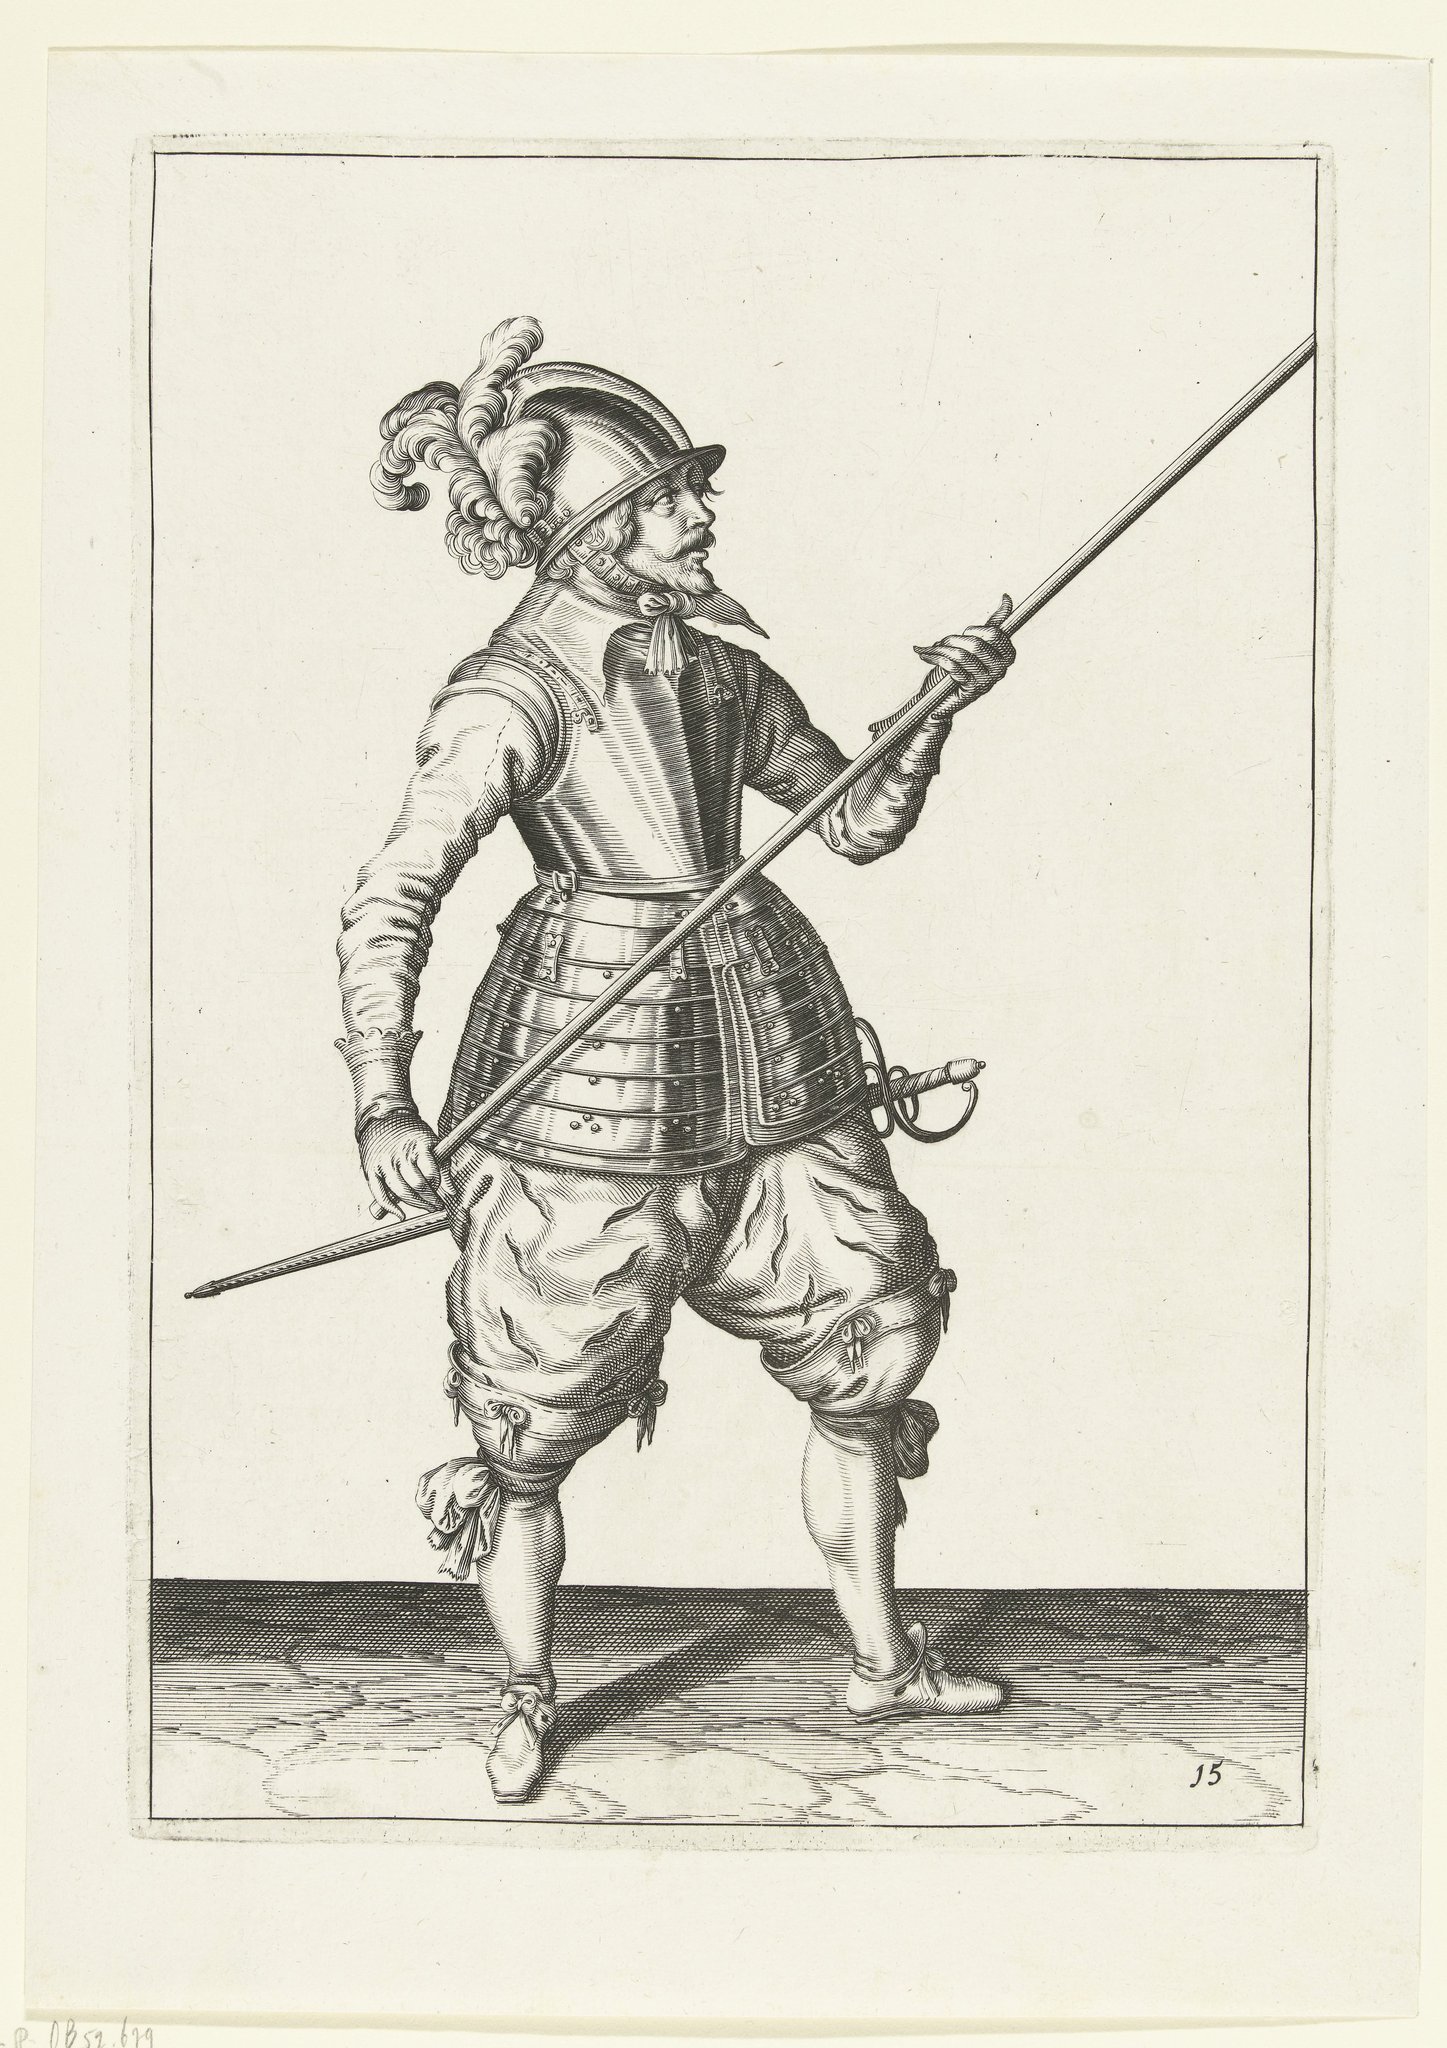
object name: print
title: Soldaat die zijn spies met beide handen bij zijn rechterzijde draagt, de punt schuin omhoog gericht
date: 1597-1607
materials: paper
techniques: engraving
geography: netherlands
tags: manoeuvre ~ military training, warfare; military affairs (+ mercenary troops, e.g.: lansquenets), helved weapons, polearms (for striking, hacking, thrusting): lance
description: Een soldaat, ten voeten uit, die een spies (lans) met beide handen bij zijn rechterzijde draagt, de punt schuin omhoog gericht. Dit is de eerste handeling voor het op de grond plaatsen van de spies. Deze prent is onderdeel van de reeks van 32 genummerde prenten van spiesdragers uit de Wapenhandelinghe.